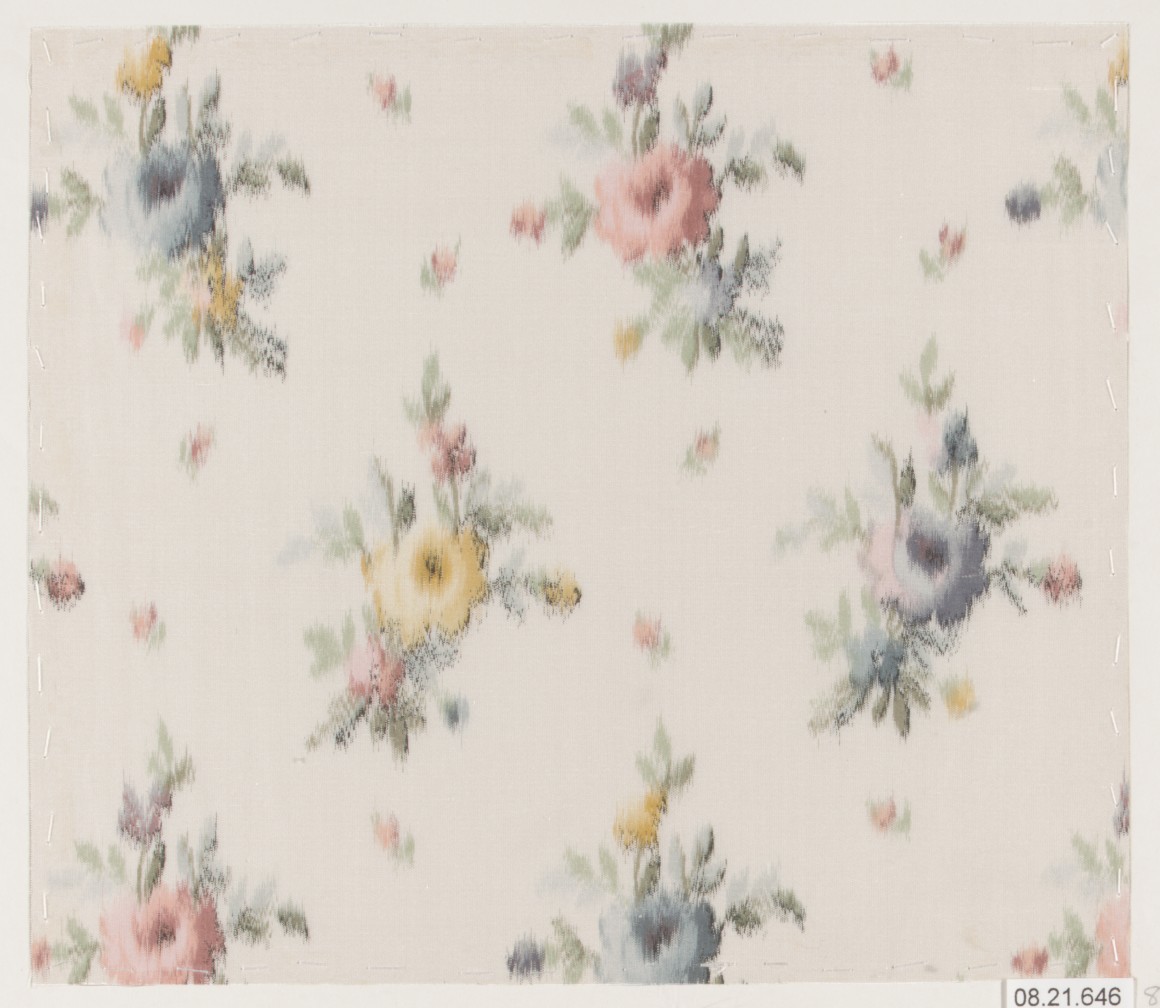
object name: textile sample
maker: Anonymous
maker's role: designer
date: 1900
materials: silk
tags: flowers